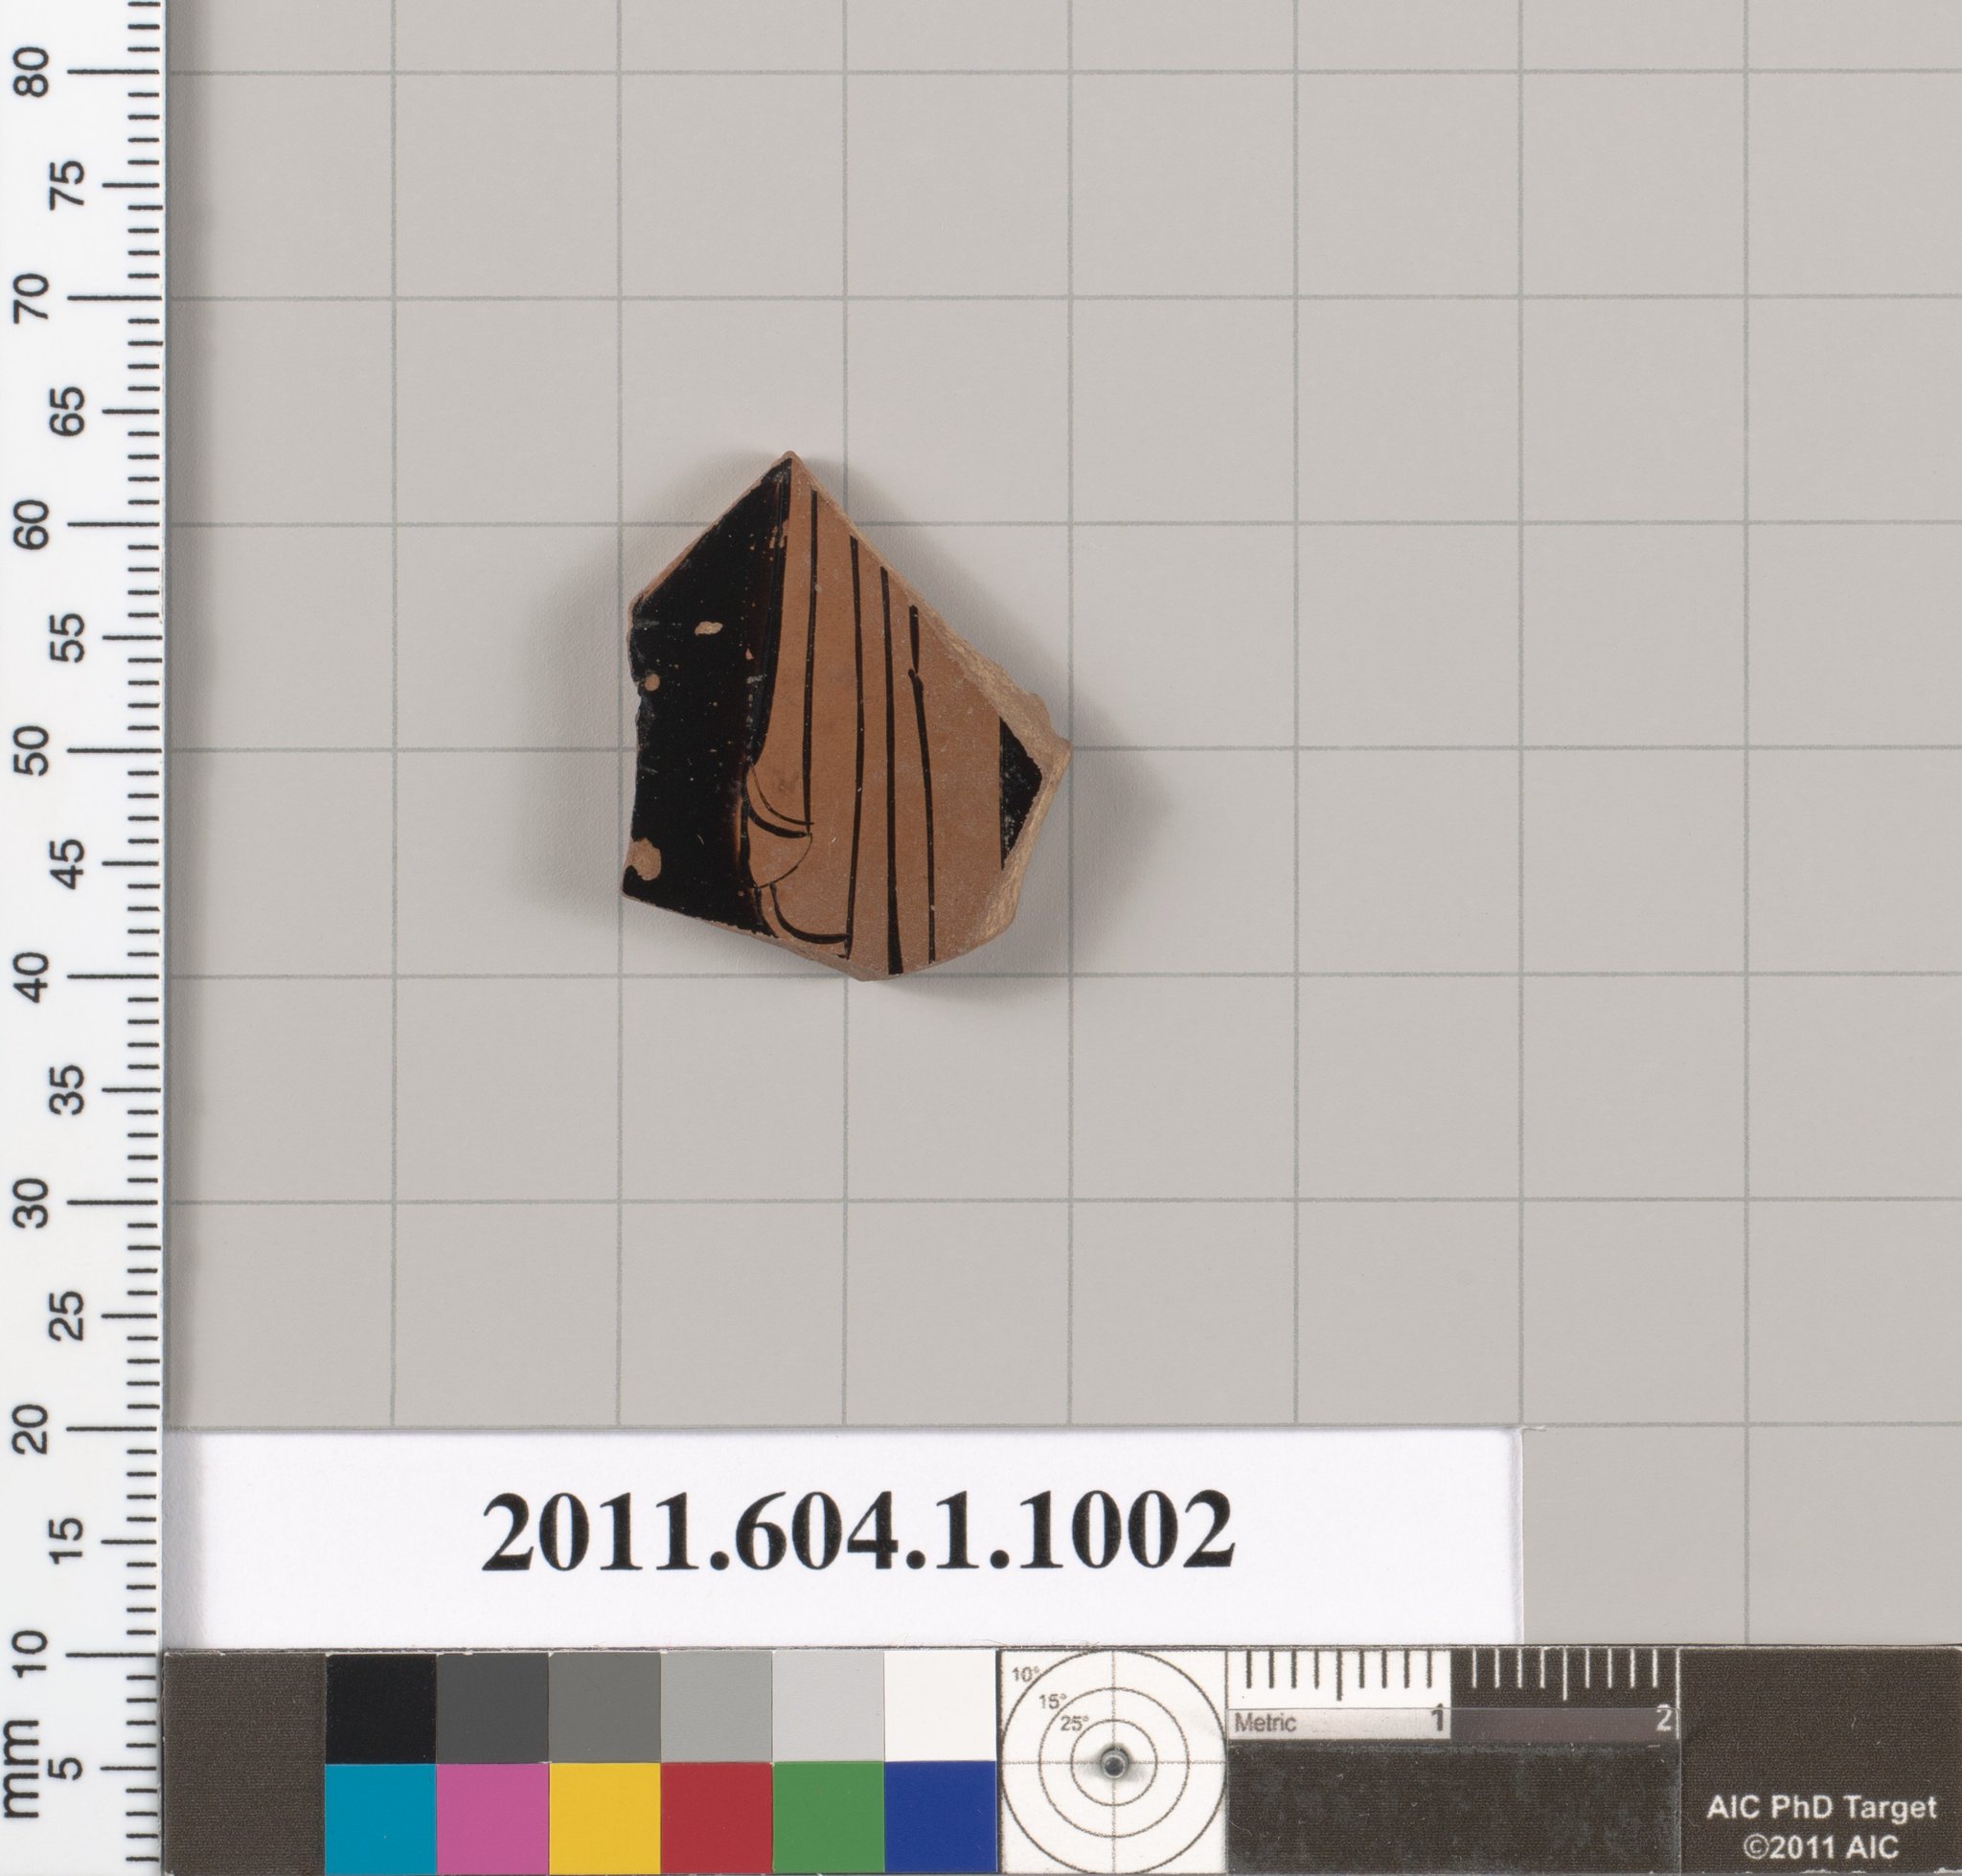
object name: kylix fragment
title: Terracotta fragment of a kylix (drinking cup)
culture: greek, attic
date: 475-451 BCE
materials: terracotta